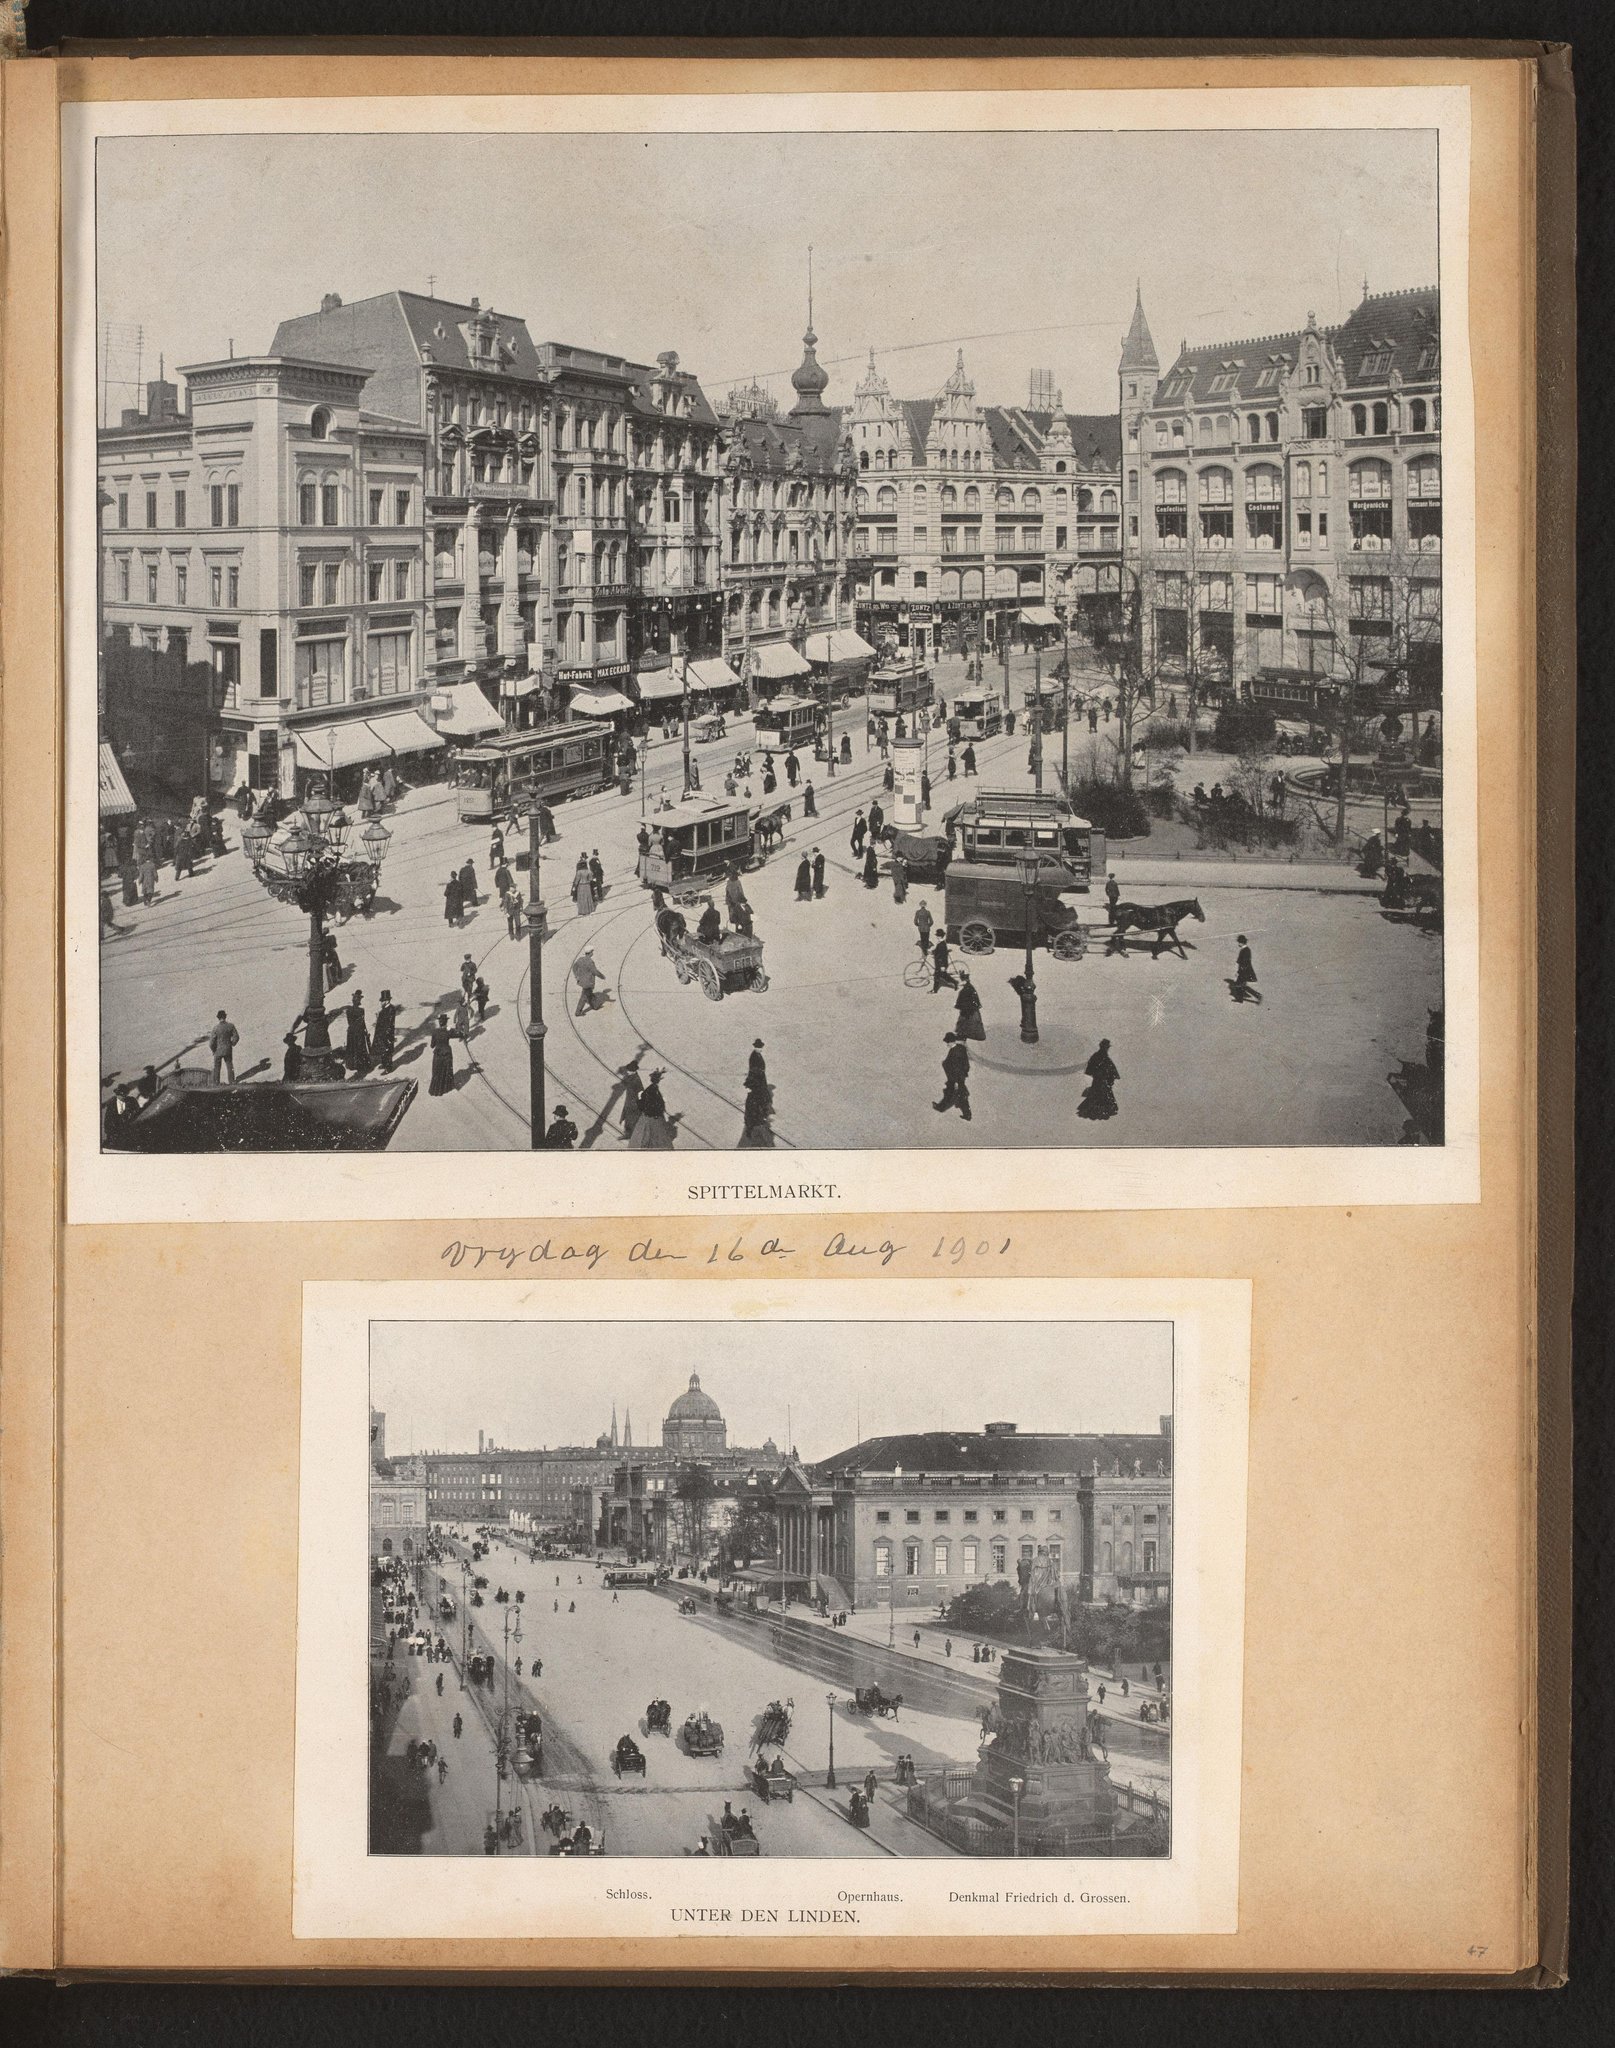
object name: photomechanical print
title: Gezicht op de Spittelmarkt en op Unter den Linden, Berlijn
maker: Anonymous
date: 1896-1901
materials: paper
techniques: autotype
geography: berlin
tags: square, place, circus, etc., avenue, boulevard, promenade, esplanade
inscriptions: title: ‘Spittelmarkt’, inscription: ‘Schloss. Opernhaus. Denkmal Friedrich d. Grossen./ Unter den Linden.’, inscription: ‘Vrijdag den 16de Aug 1901’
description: Deze fotomechanische afdrukken maken deel uit van een album.